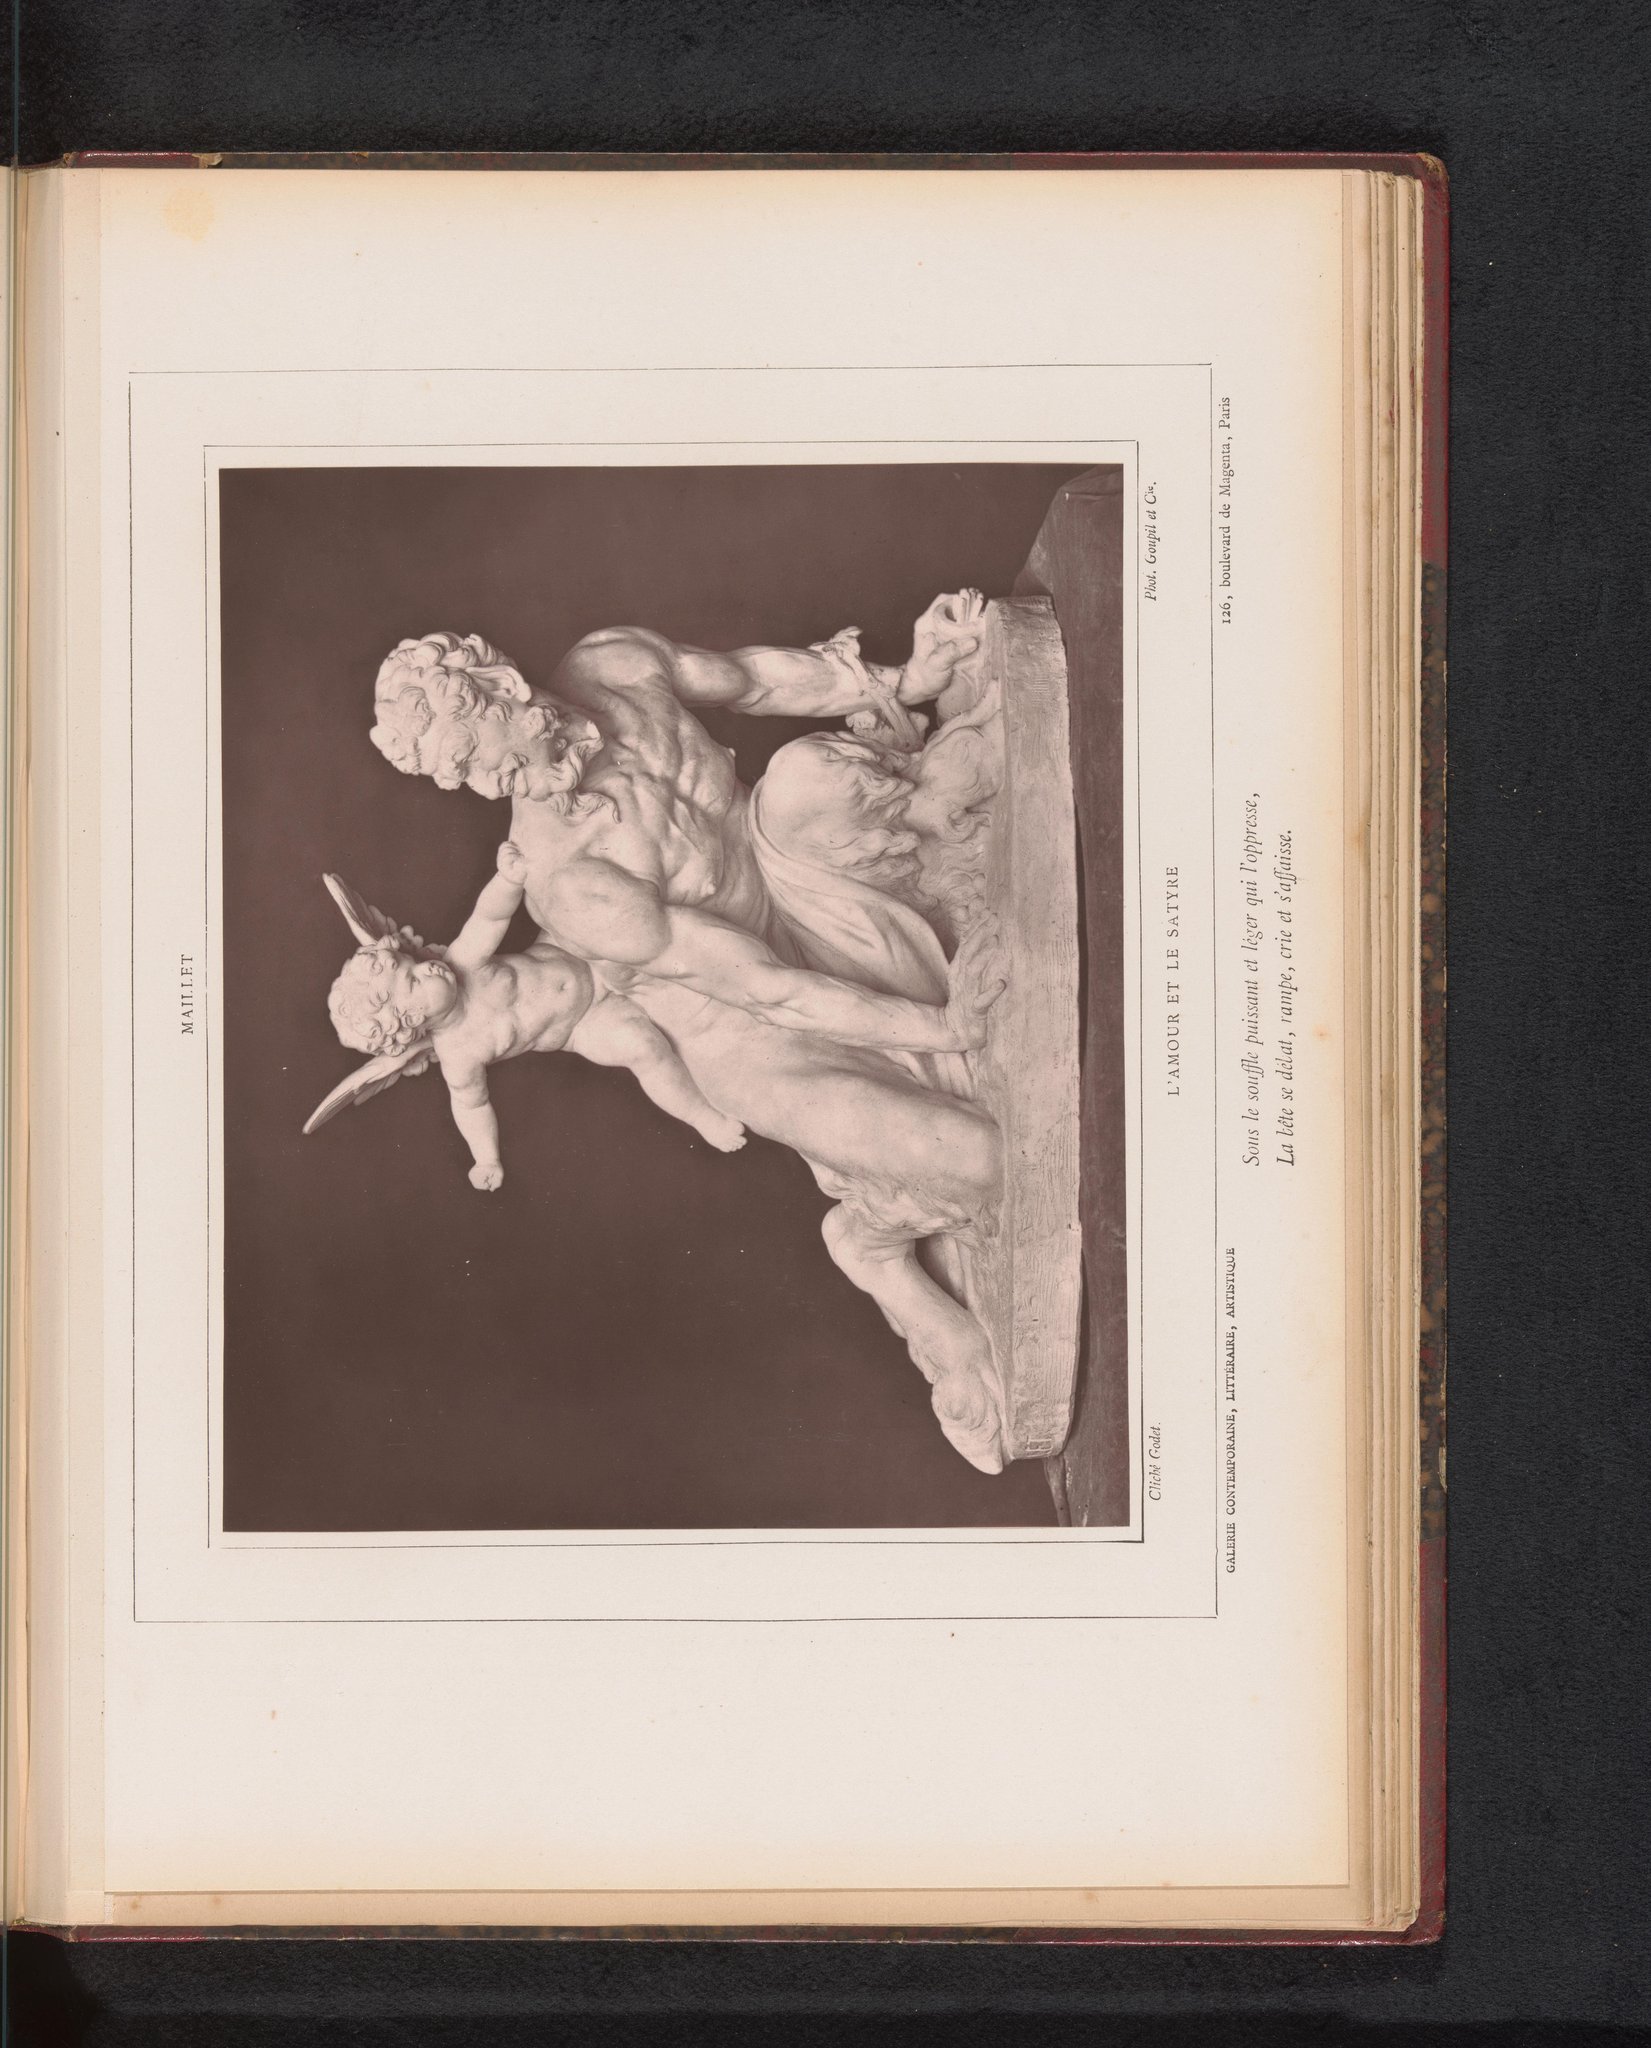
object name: photomechanical print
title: Sculptuur l'Amour et le satyre door Jacques-Léonard Maillet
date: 1871-1876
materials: paper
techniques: woodburytype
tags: satyr(s) (in general), sculpture, cupids: 'amores', 'amoretti', 'putti'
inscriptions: inscription: ‘Galerie Contemporaine, Littéraire, Artistique/ 126, boulevard de Magenta, Paris’